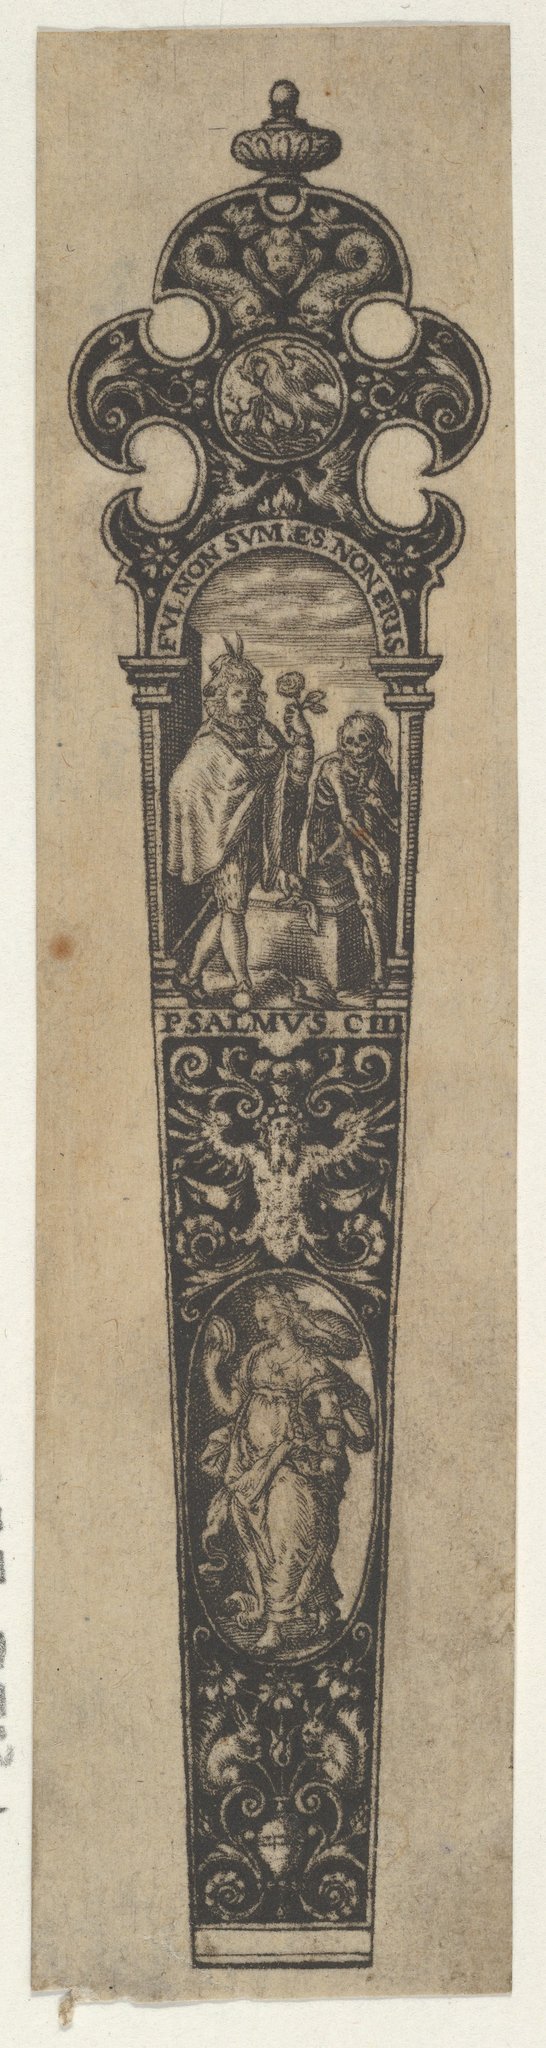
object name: print ornament architecture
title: Design for a Knife Handle with a Memento Mori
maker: johann theodor de bry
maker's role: artist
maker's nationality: netherlandish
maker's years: 1561-1623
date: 1580-1600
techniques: embroidery, engraving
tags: animals,women